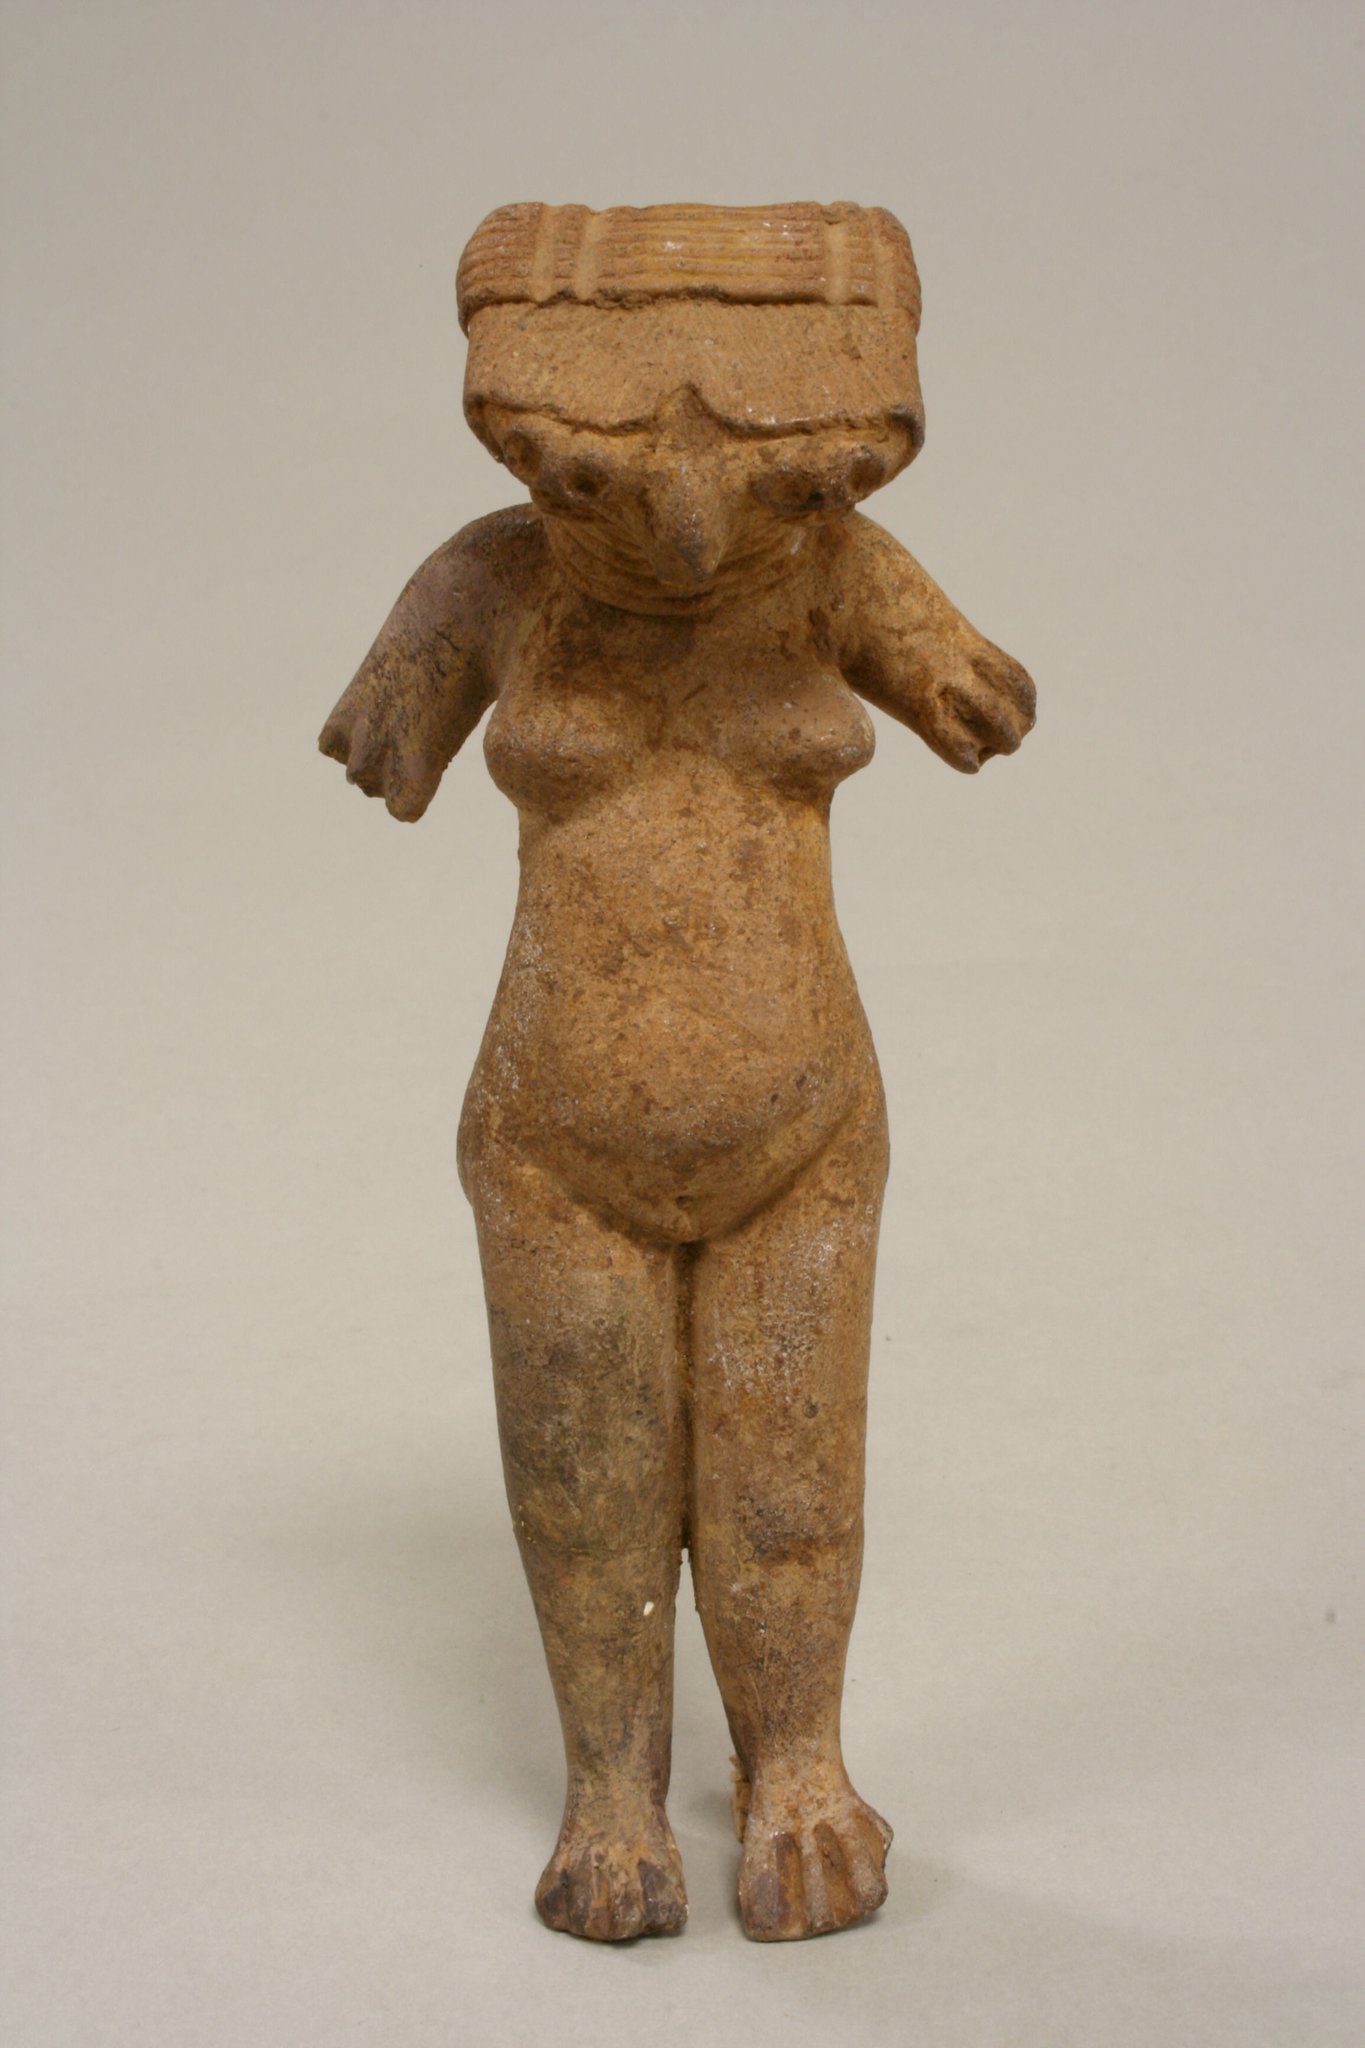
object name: female figure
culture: michoacan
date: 1001-1600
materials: ceramic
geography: mexico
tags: female nudes